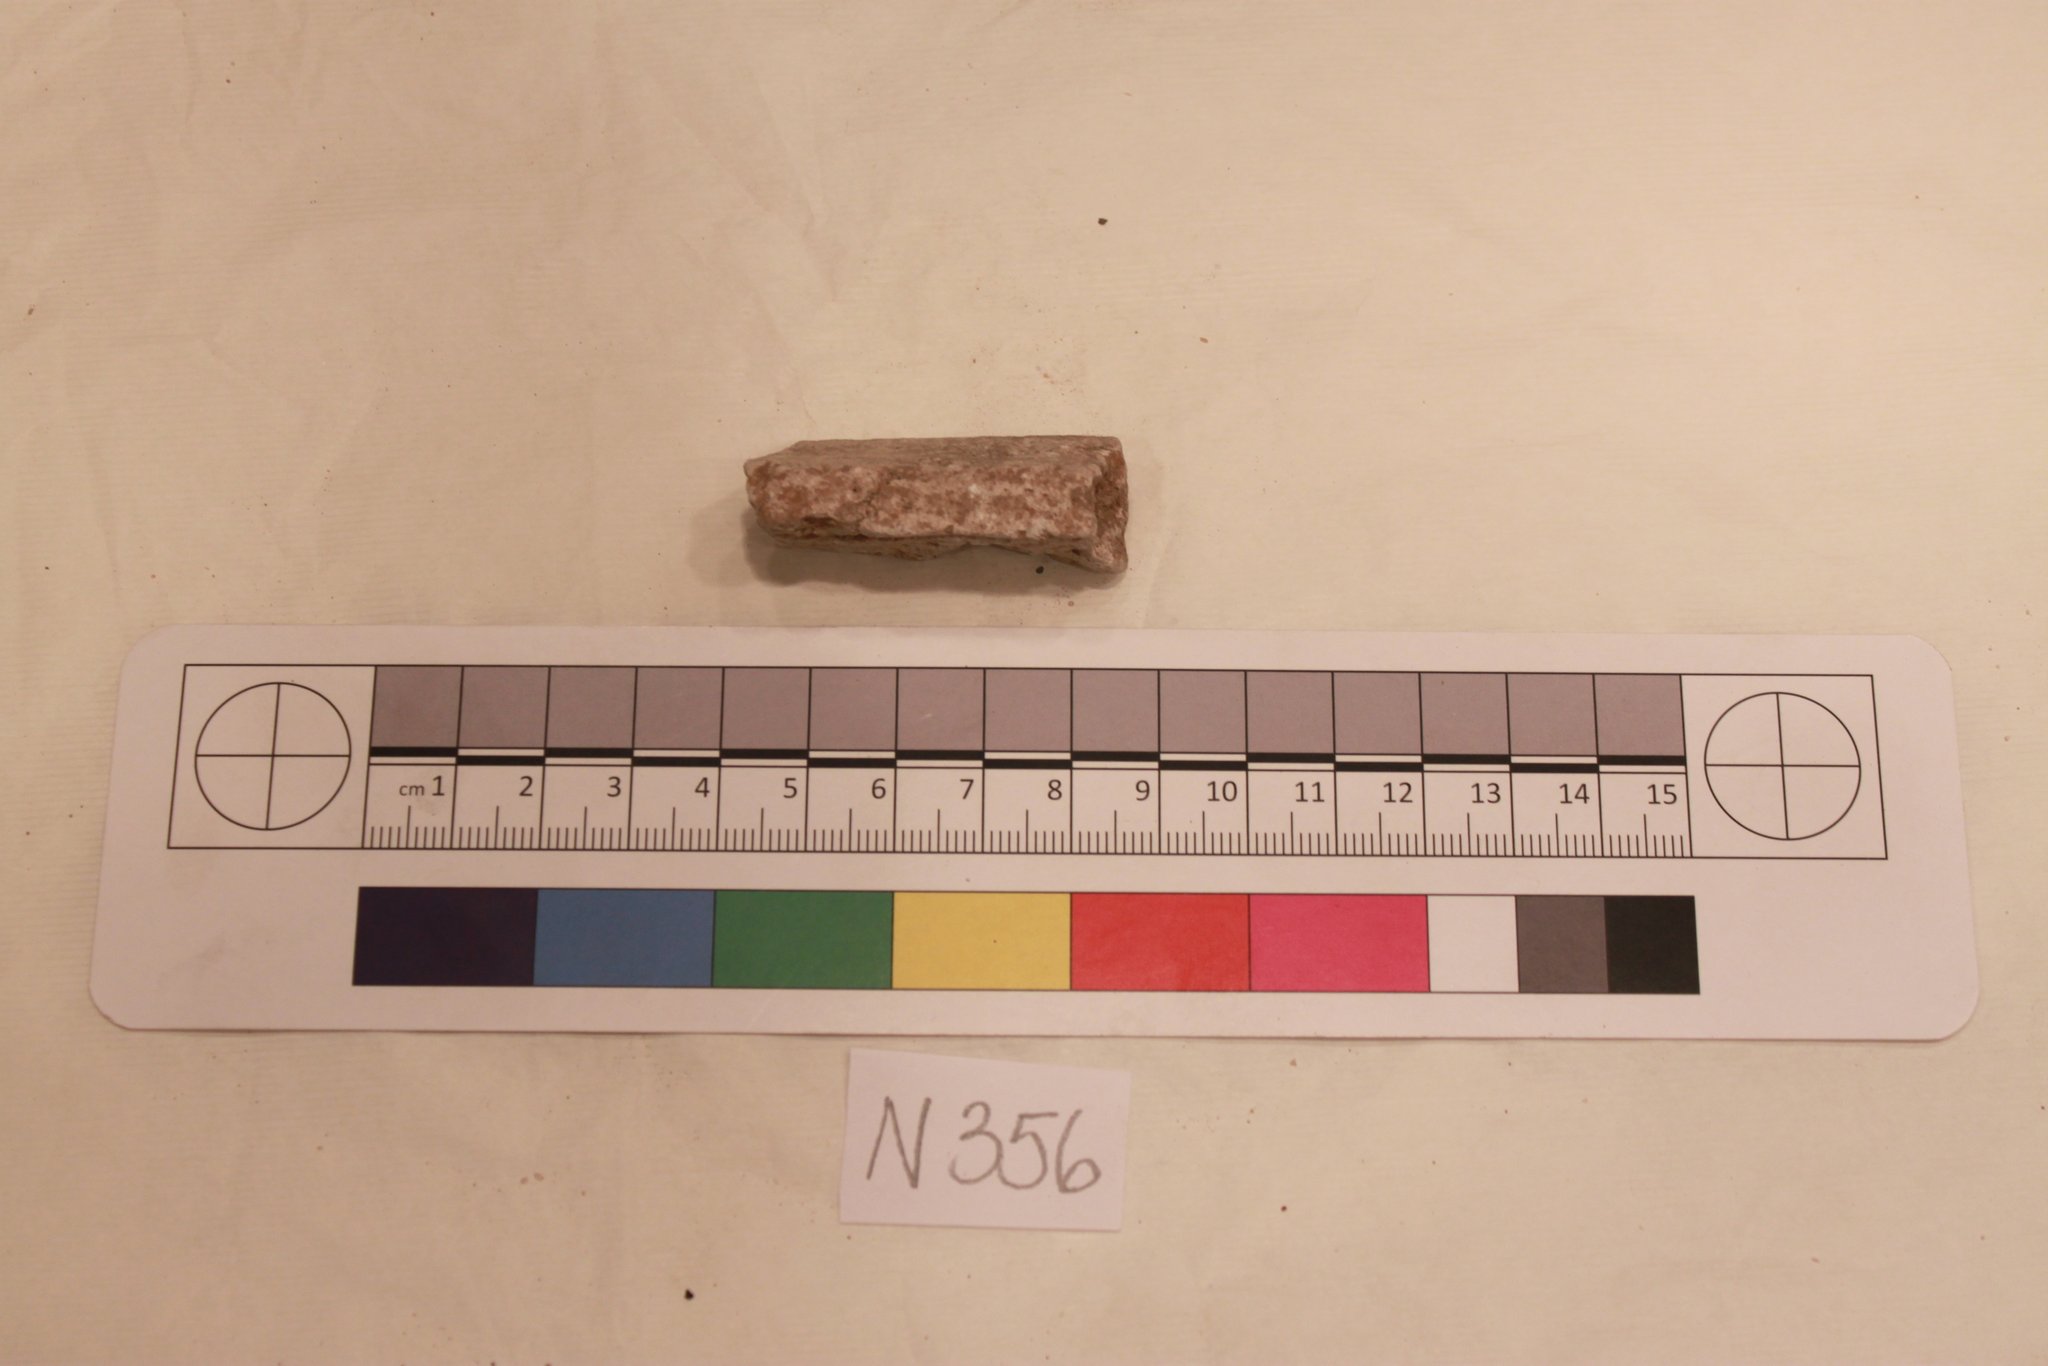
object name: fragment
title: Stucco Fragment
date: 701-1200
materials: plaster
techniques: carving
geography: iran